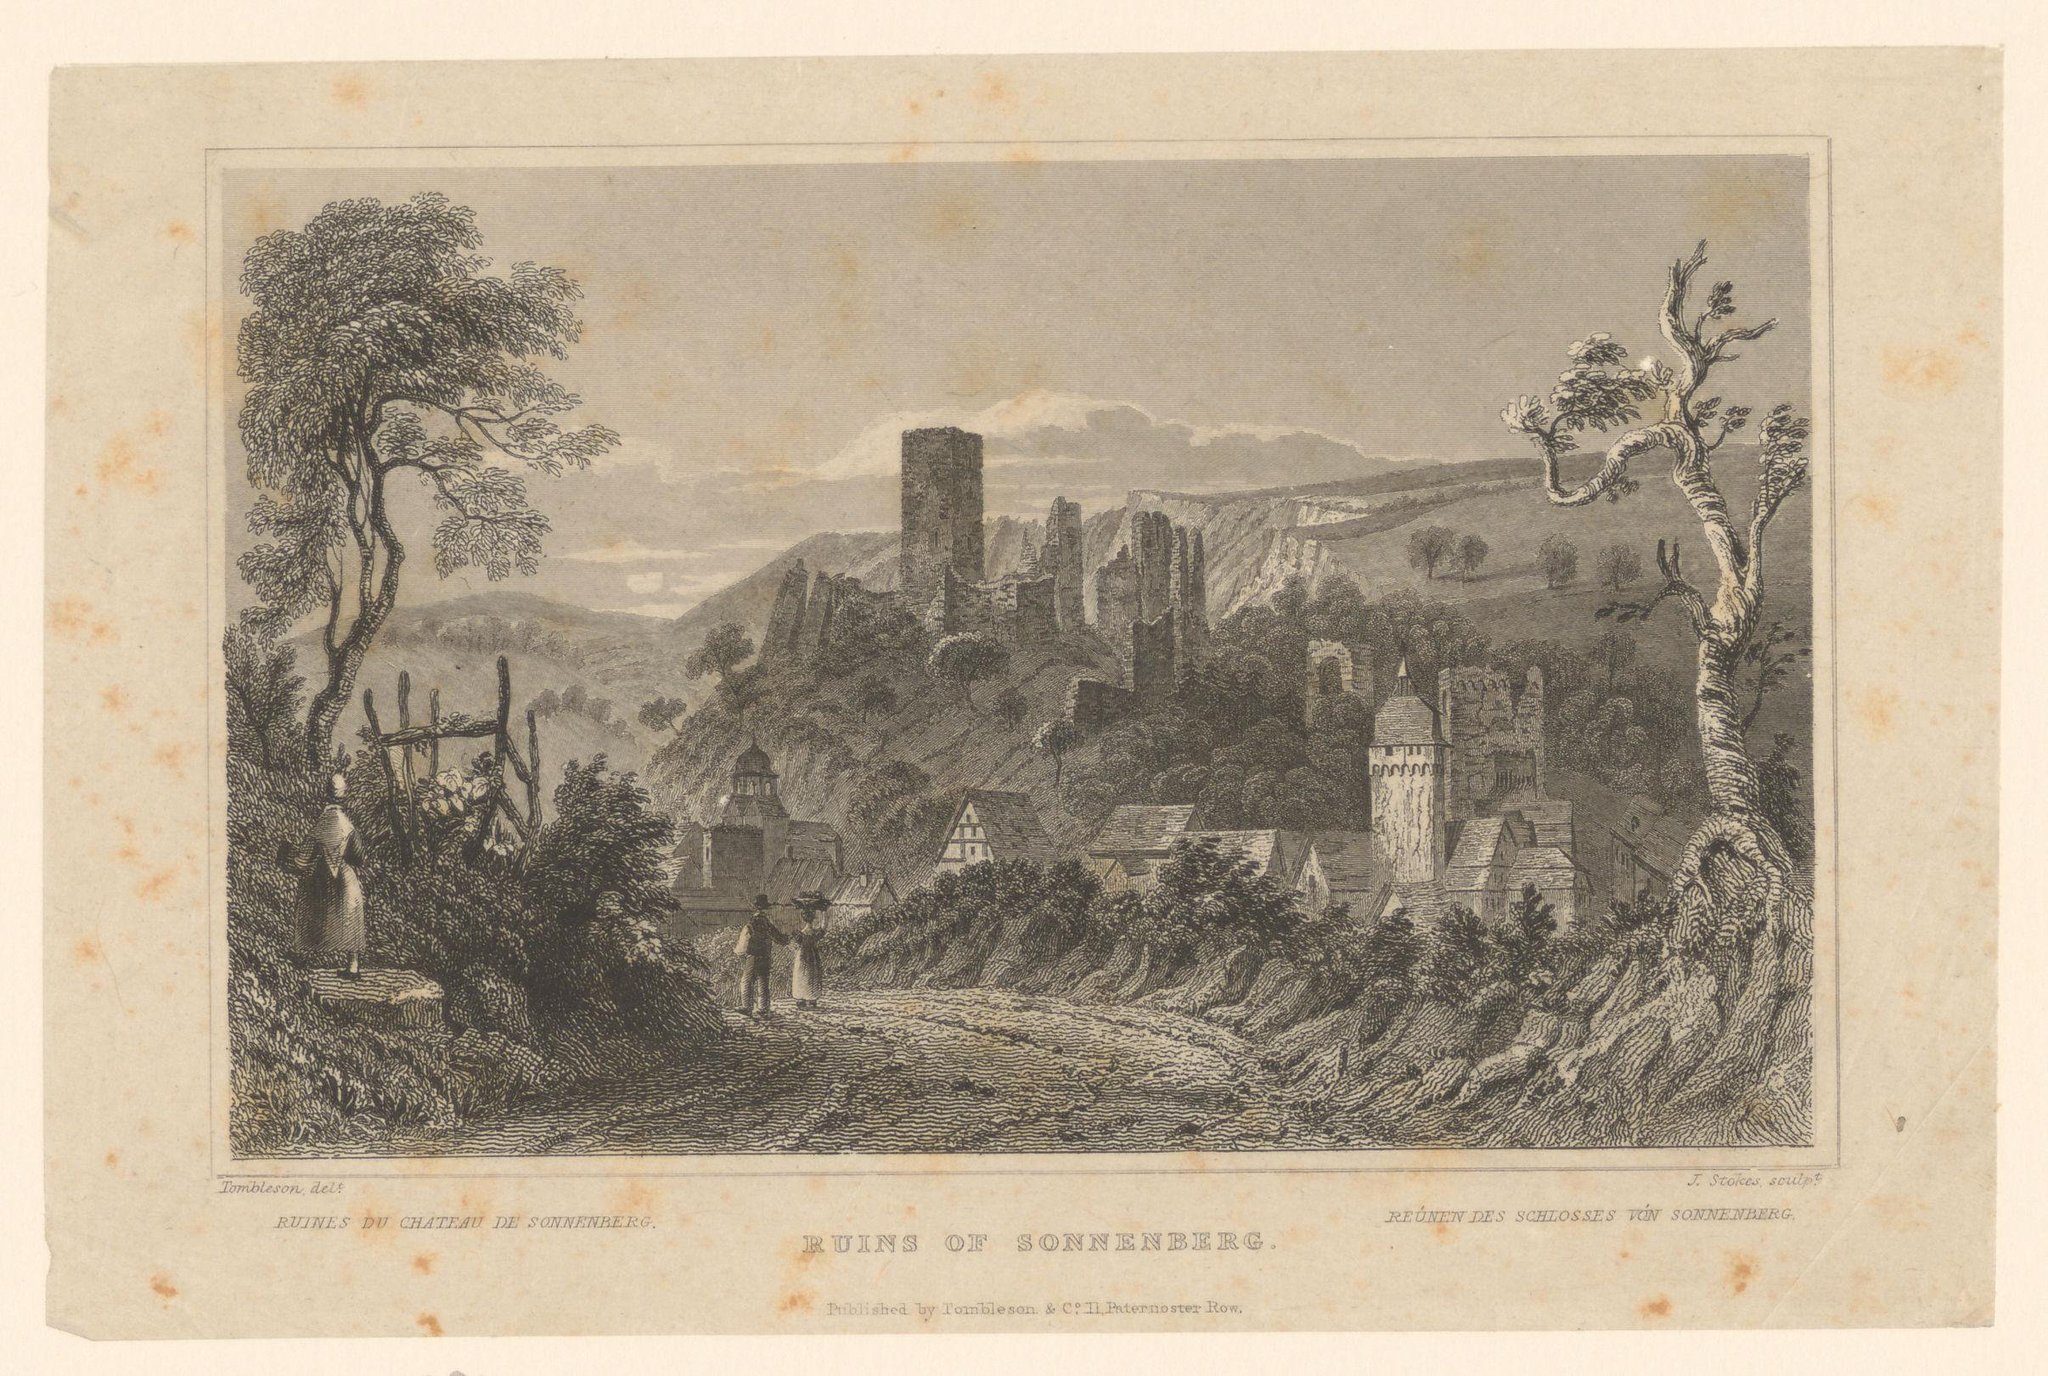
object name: book illustration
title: Gezicht op de ruïne van Sonnenberg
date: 1832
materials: paper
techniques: etching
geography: london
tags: landscape with ruins, ruin of a dwelling, house, castle, etc.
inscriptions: collector's mark: Lugt 2228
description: Prent uit: Tombleson, William. Tombleson's Views of the Rhine. Londen: Tombleson & Co., 1832, dl. 1.